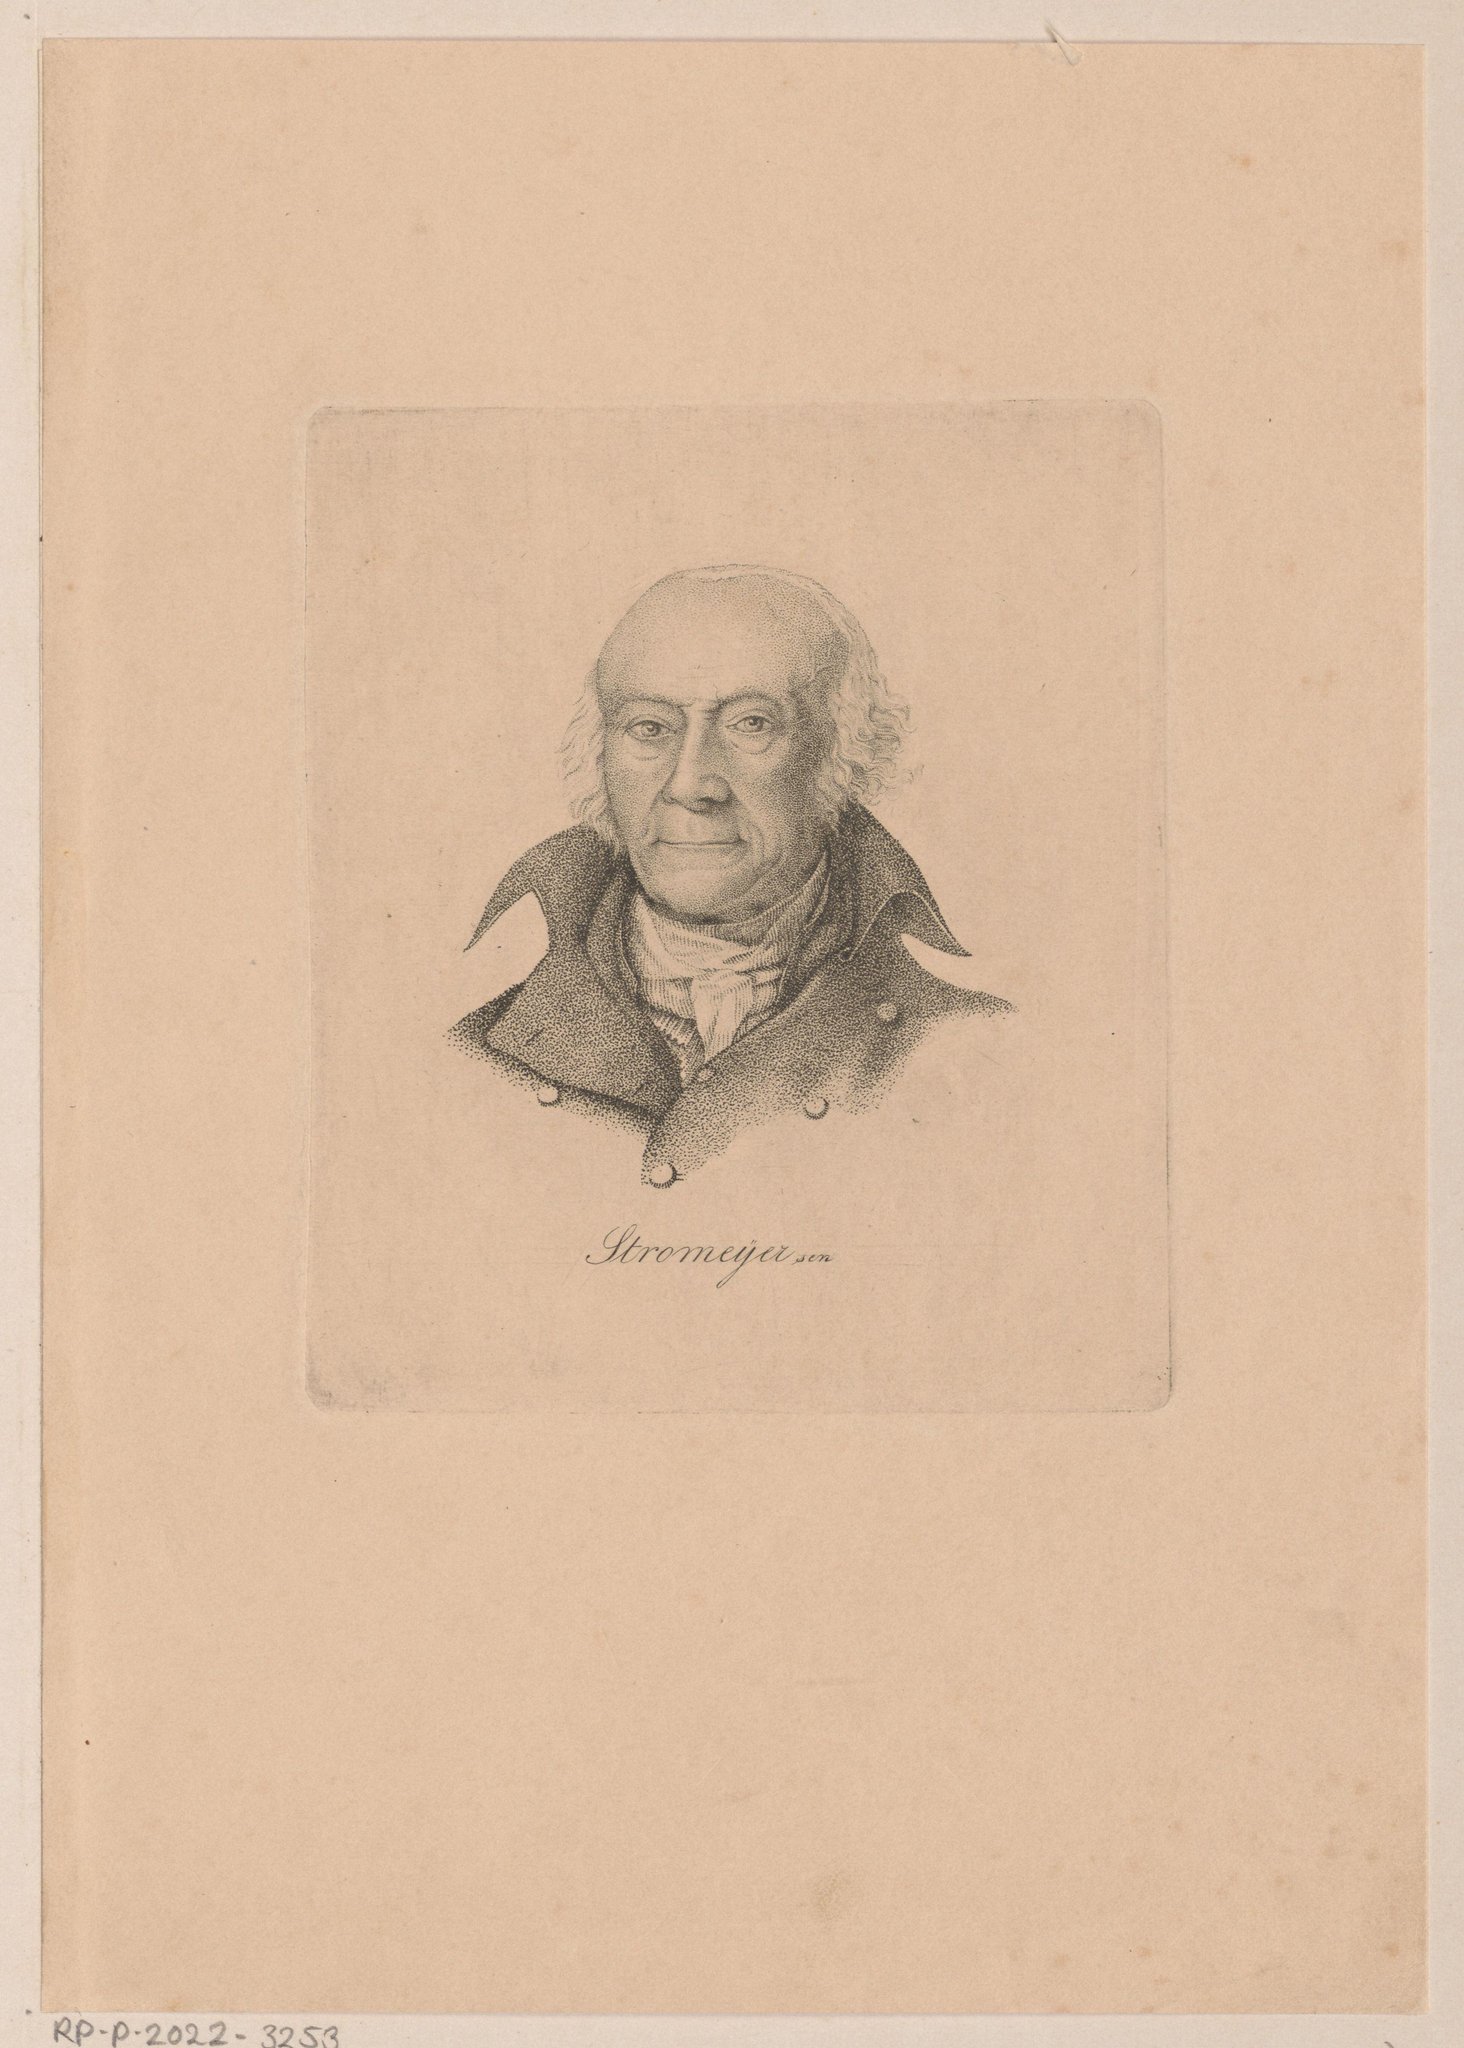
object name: print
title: Portret van Johann Friedrich Stromeyer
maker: Anonymous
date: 1800-1850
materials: paper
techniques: engraving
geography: germany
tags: historical persons, physician, doctor, professor